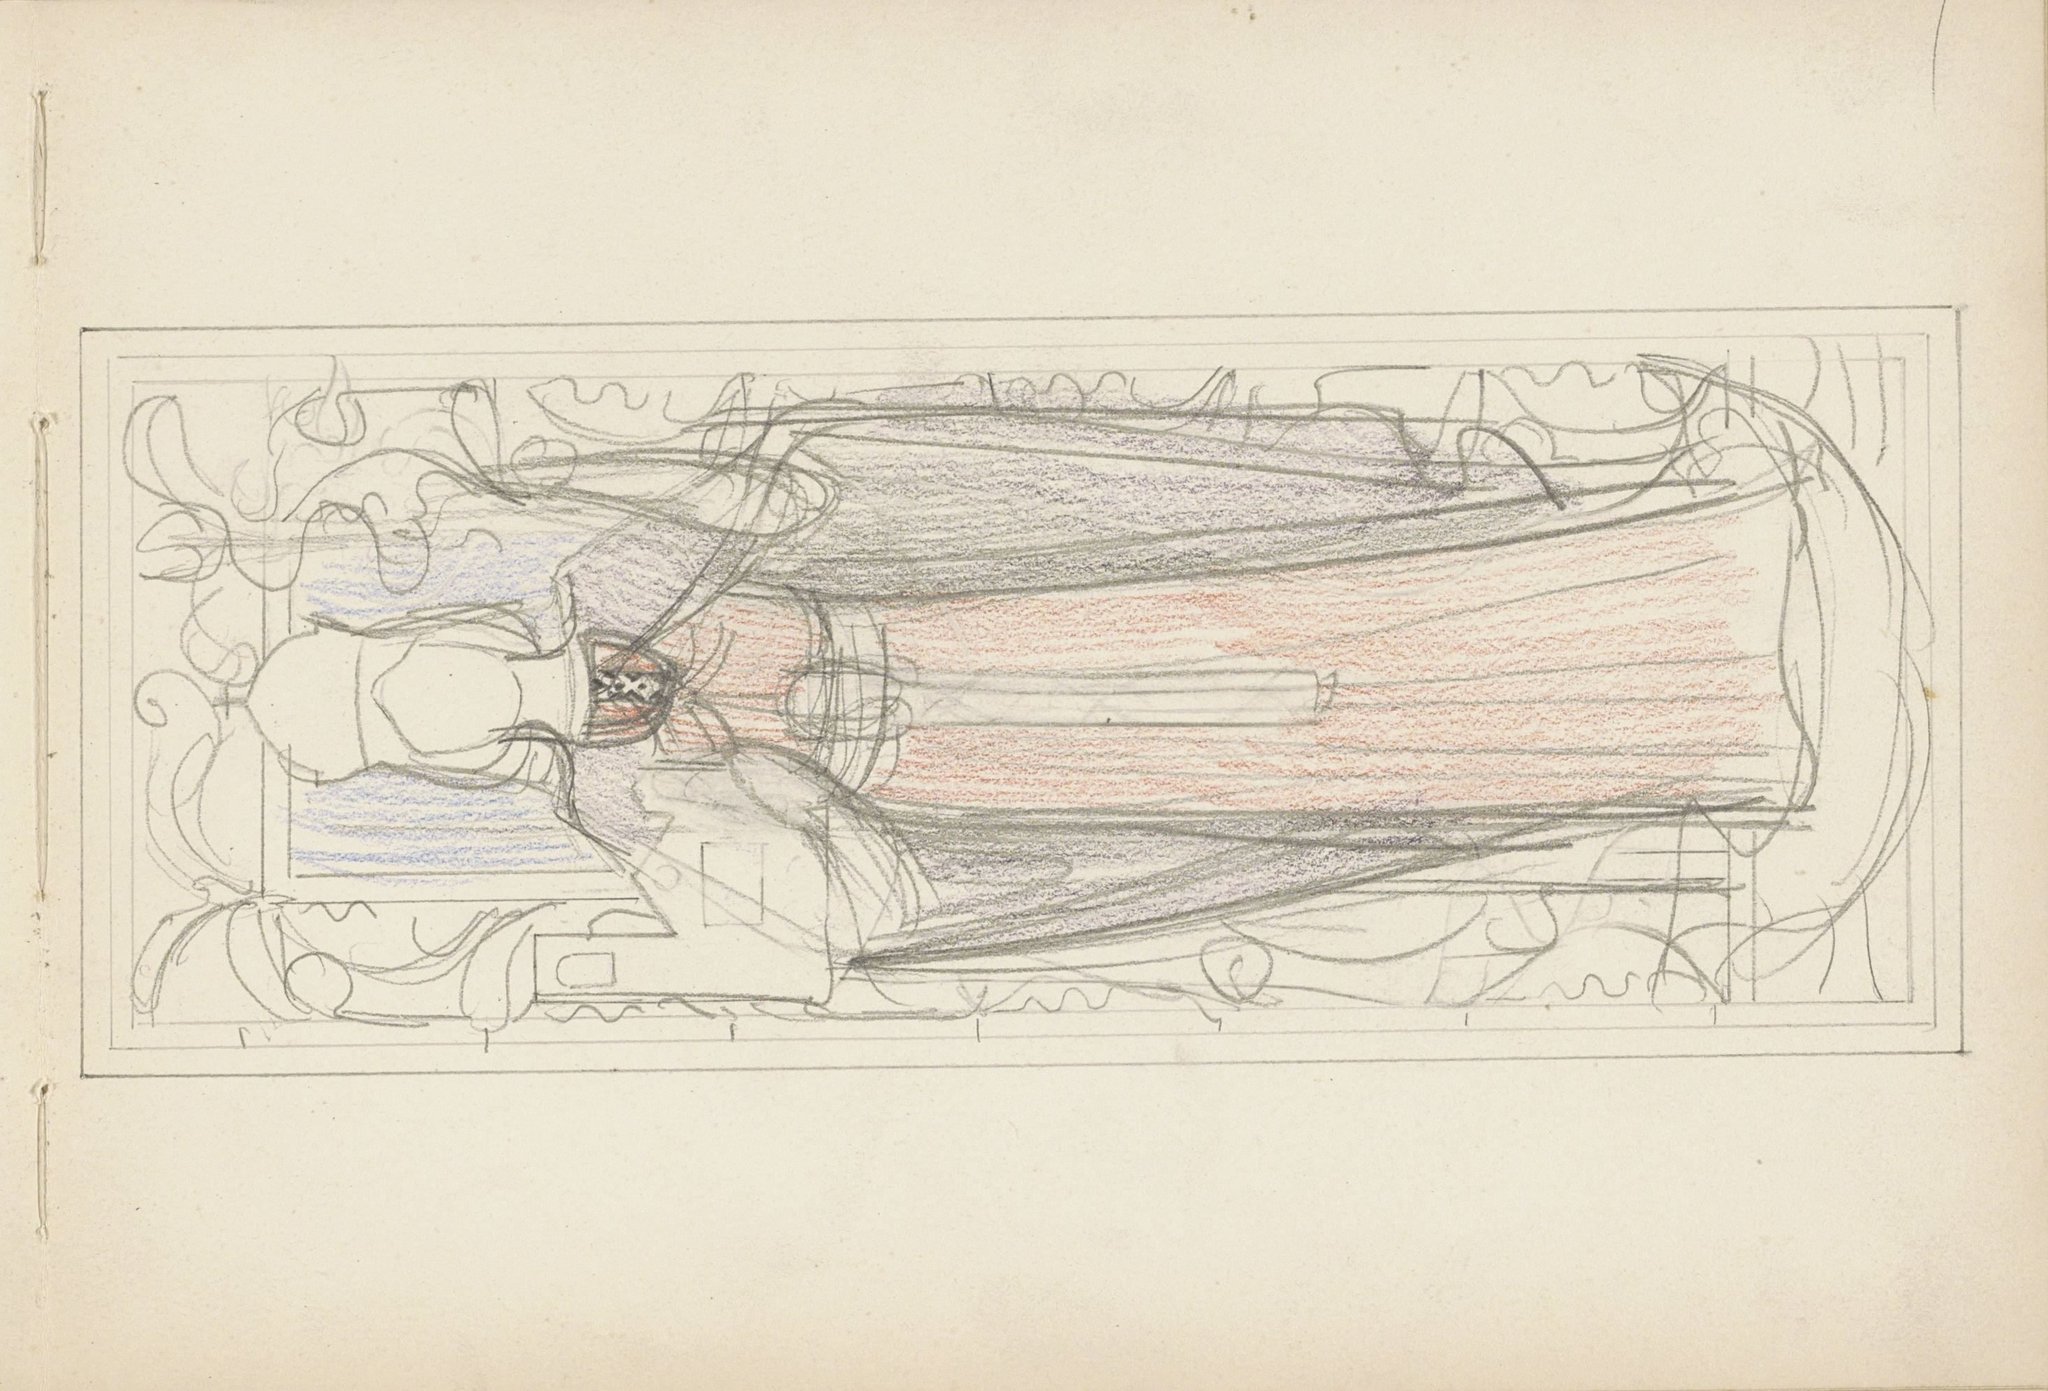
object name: sketchbook leaf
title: Amsterdamse stedenmaagd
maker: antoon derkinderen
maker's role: draughtsman, painter, print maker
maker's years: 1859-1925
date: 1900-1903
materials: paper, pencil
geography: amsterdam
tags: window, personification of a city, town-patron(ess), amsterdam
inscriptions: annotation: ‘Des wijzes koopman slacht, die 't beste deel/ verkiest/ En om de schoonste peerle is weinig goeds/ versiert/ (Vondel)/ Aan het Stadhuis Zij is omringd van alle roosters van lei-/ gereedschap. Aan hare voeten/ Ik zie Hel[...] wereldbol & [...]’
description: De vrouw is gekleed in een lange mantel met het stadswapen van Amsterdam op haar borst. Ze draagt een kroon en heeft beide handen opgeheven. Ontwerp voor een glas-in-loodraam voor de Kamer van Koophandel in de Beurs van Berlage te Amsterdam. Blad 19 recto uit een schetsboek met 45 bladen.